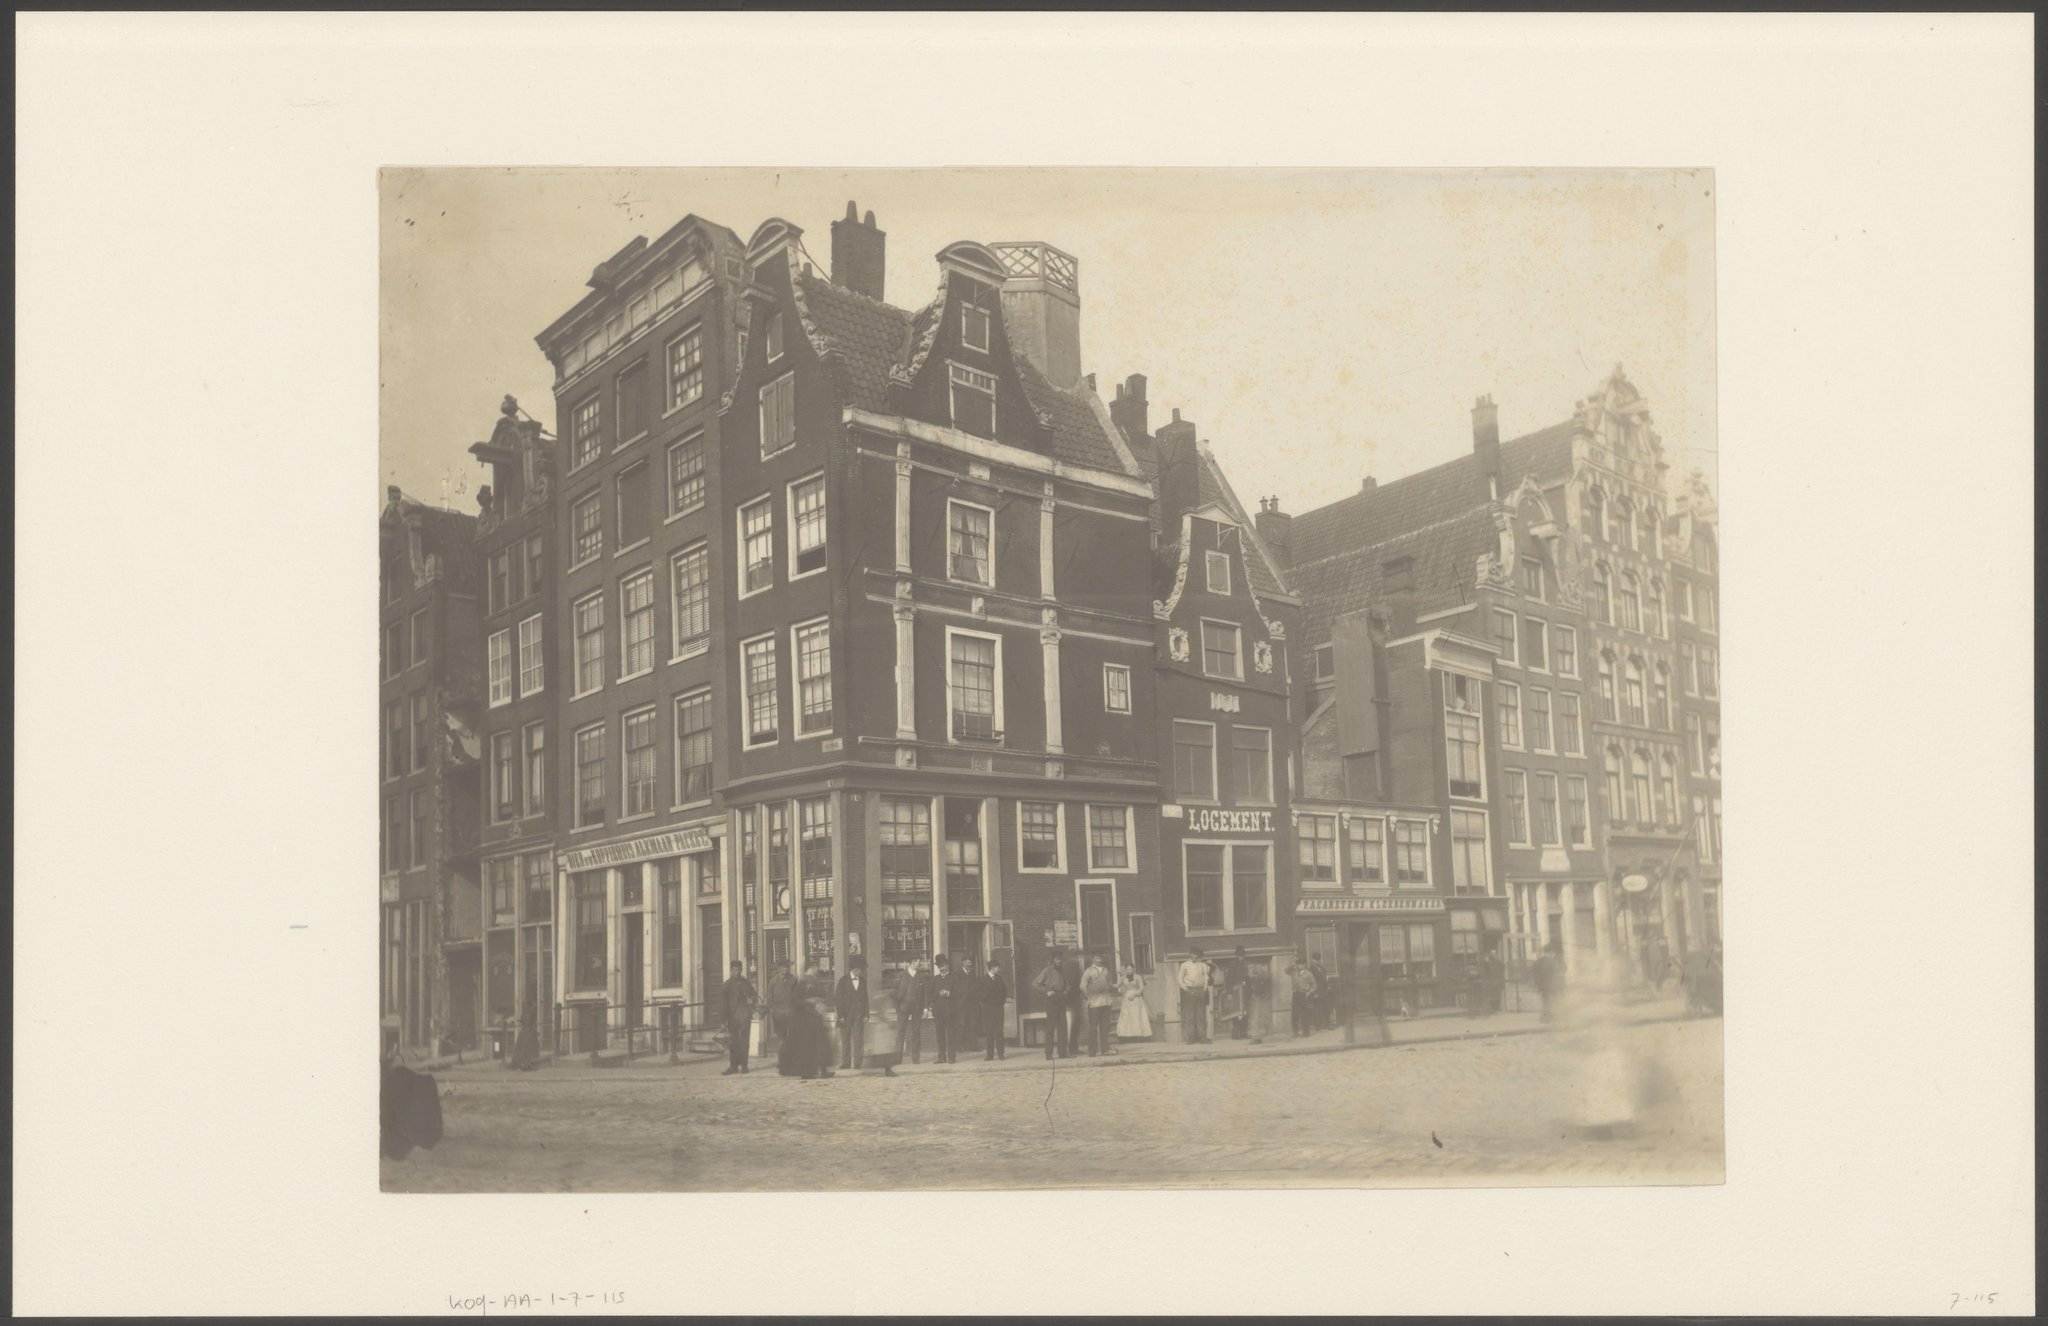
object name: photograph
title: Gezicht op een pand aan het Damrak, hoek Prins Hendrikkade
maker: Anonymous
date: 1880-1920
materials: paper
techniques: gelatin silver print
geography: amsterdam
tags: city-view in general; 'veduta', façade (of house or building), street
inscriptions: inscription: ‘K.O.G. / Atlas Amsterdam / Portefeuile 4’, collector's mark: ‘7’ Lugt 1641b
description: Onderwerpsrubriek binnen de Atlas Amsterdam: Damrak, Damstraat, Doelensluis, Doelenstraat (Nieuwe), Driehoekstraat, Droogbak, Duvelshoek, Dijkstraat en Korte -.